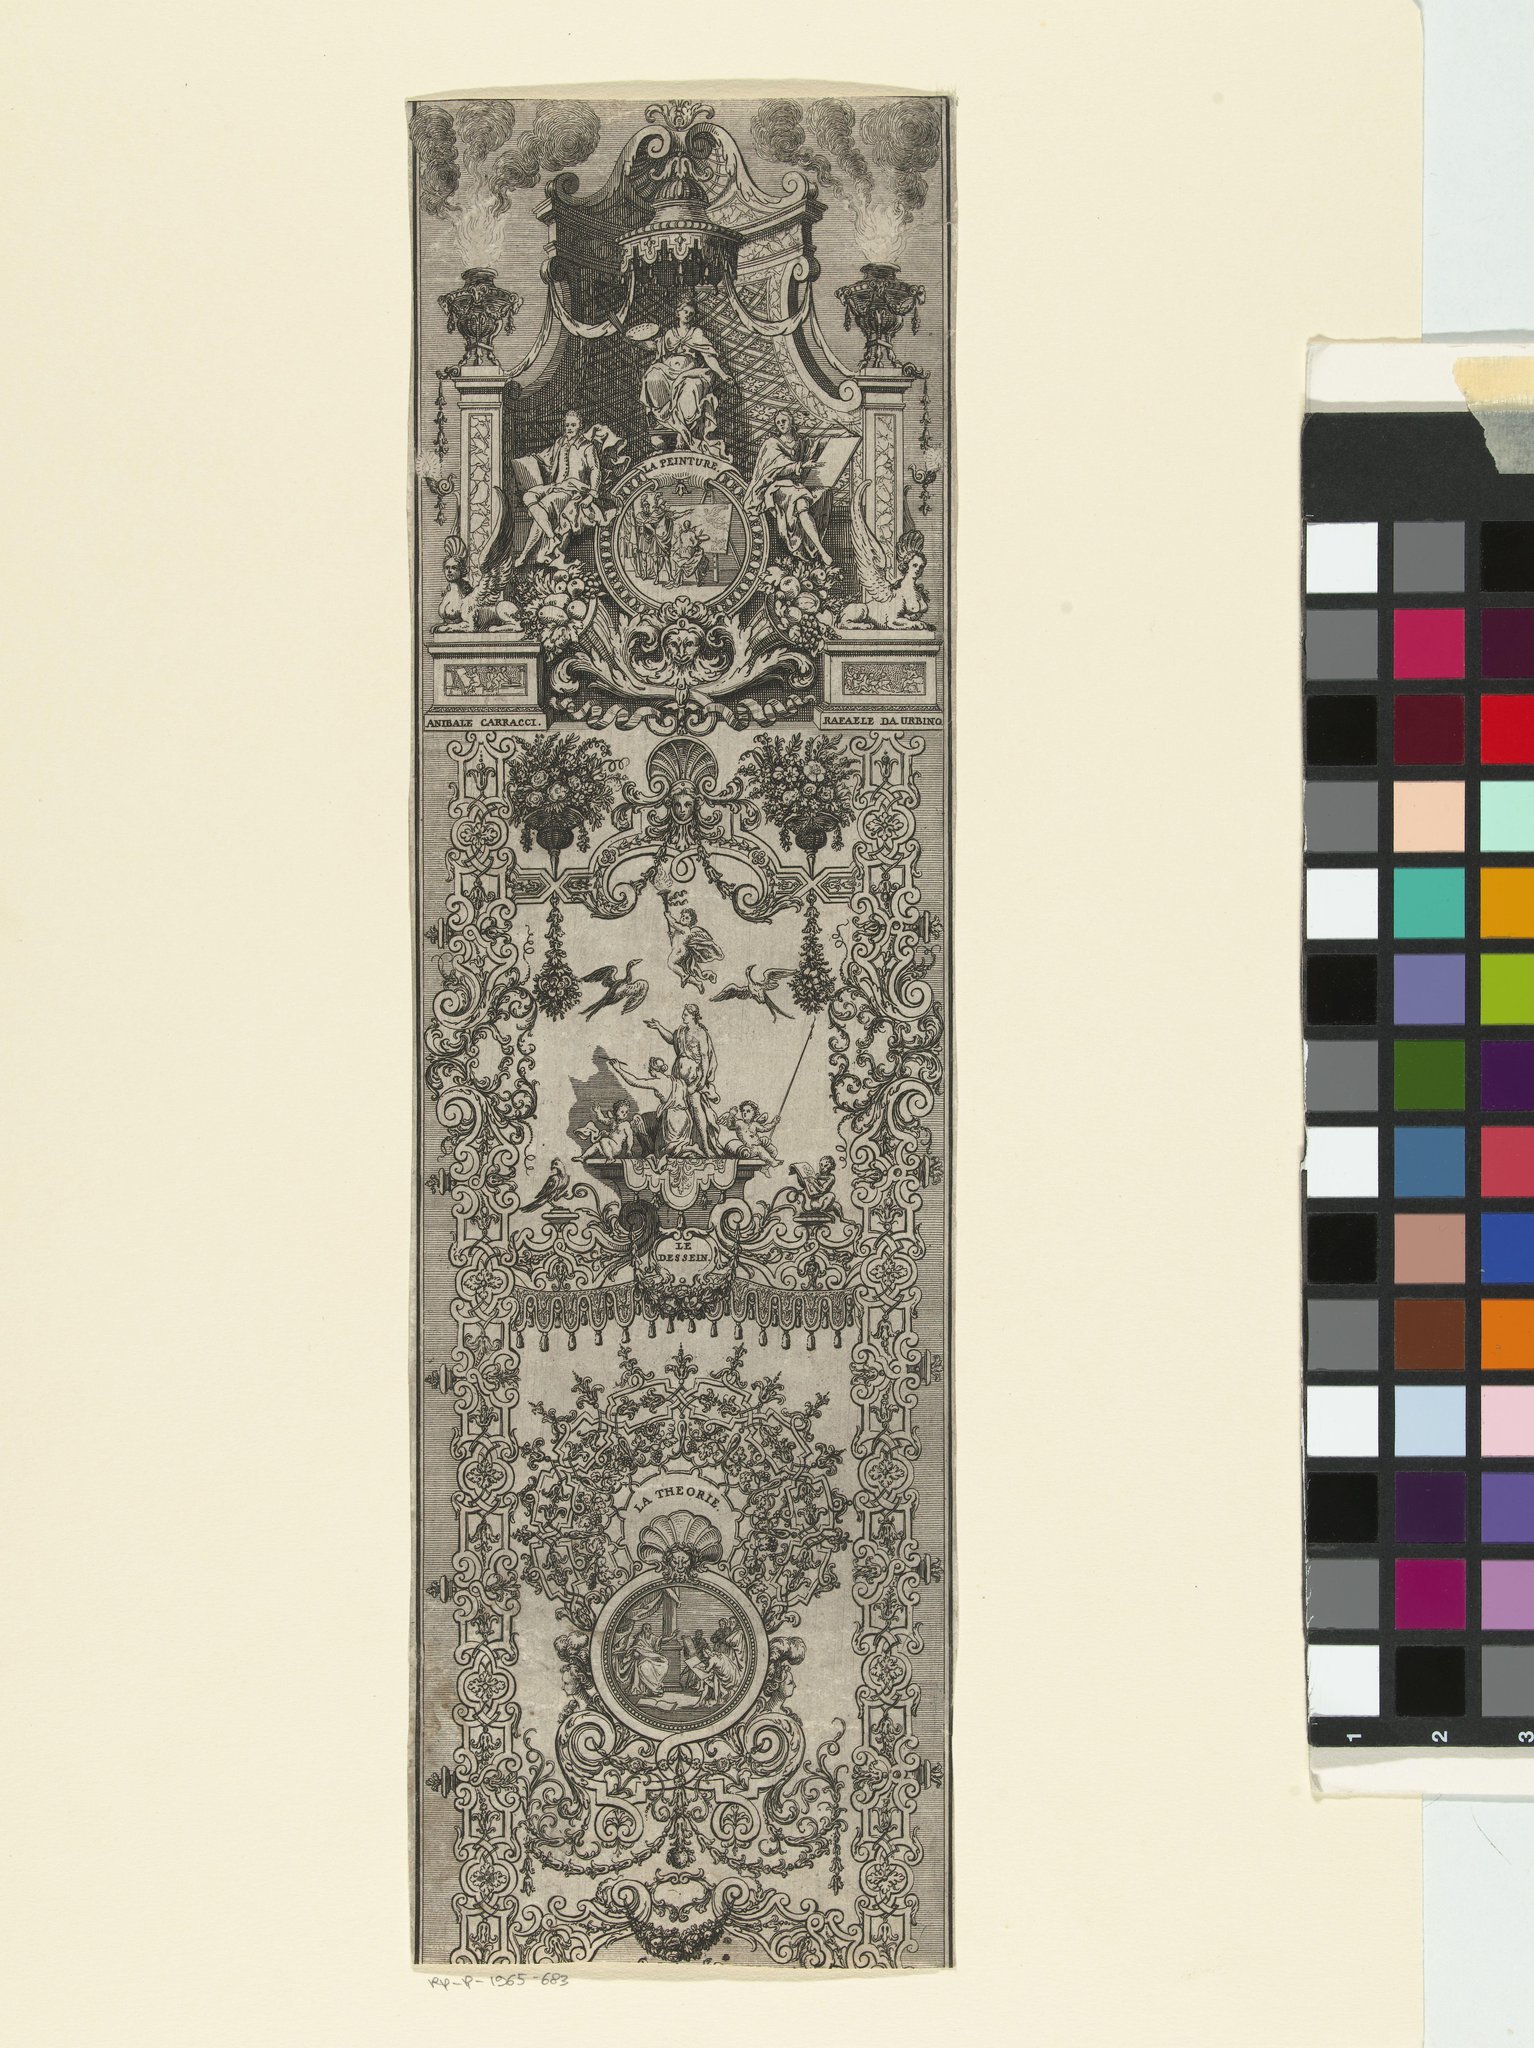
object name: print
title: La peinture / Le dessein / La theorie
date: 1647-1714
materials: paper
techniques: etching